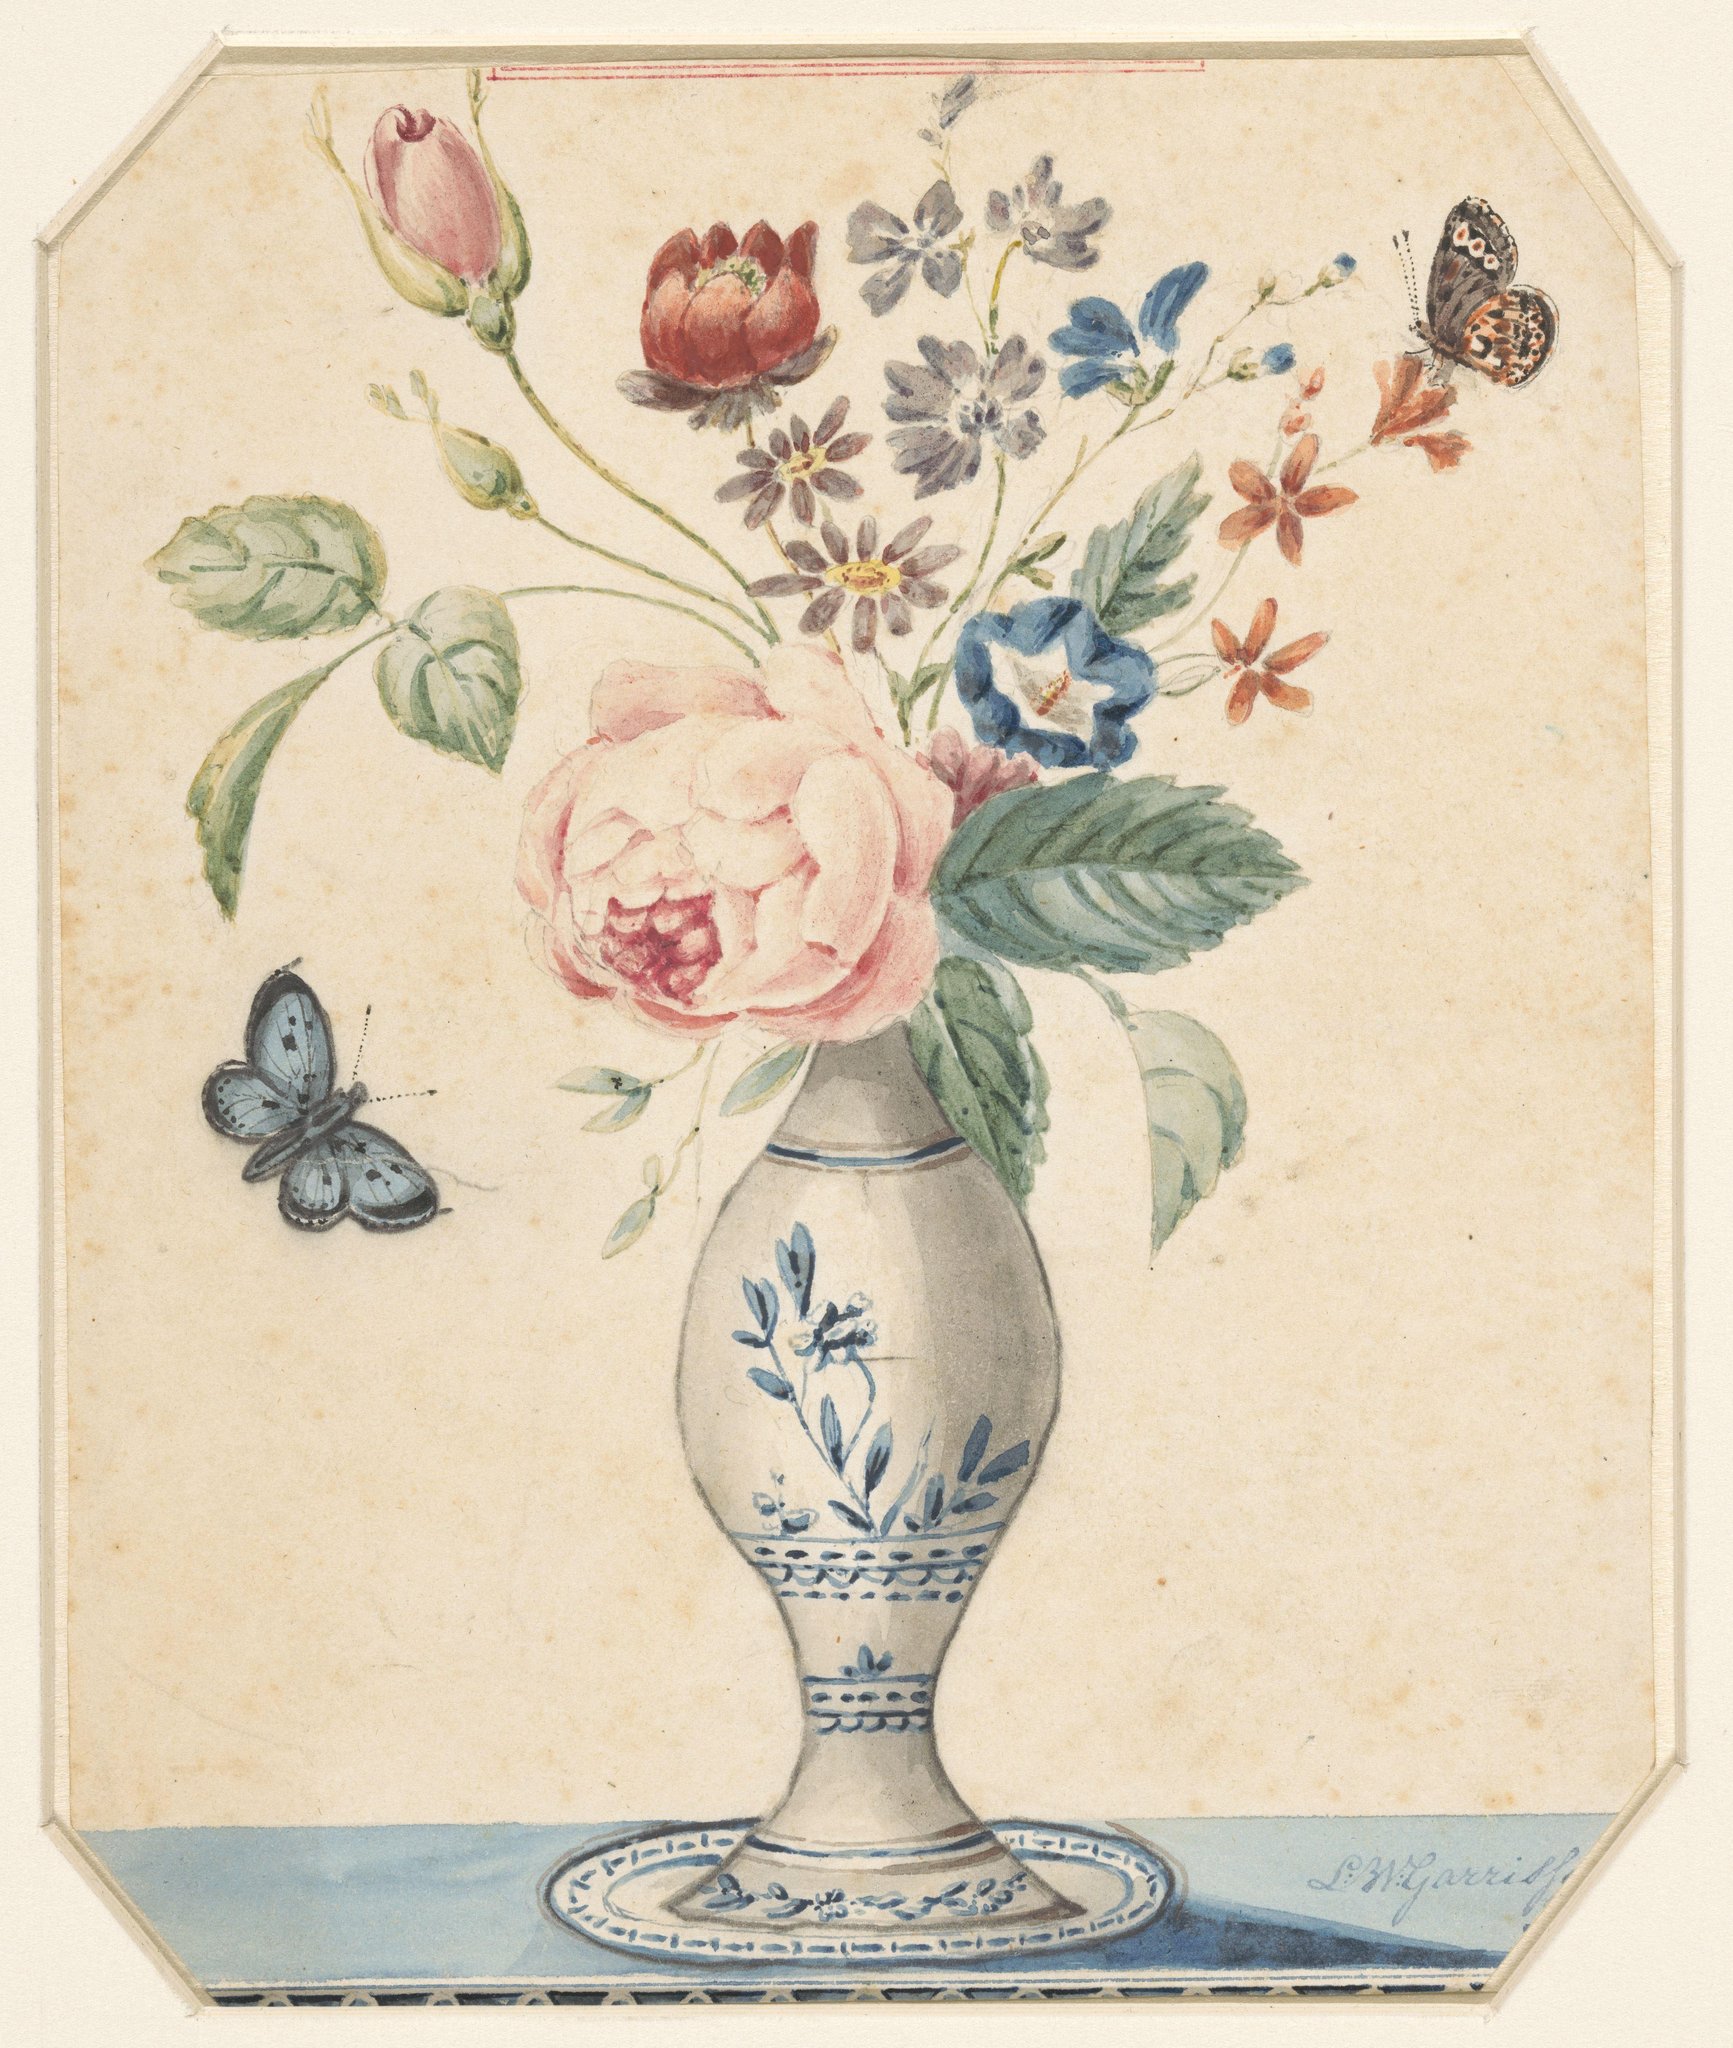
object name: drawing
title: Vaasje met bloemen en een blauwe vlinder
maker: l.w. garrison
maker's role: draughtsman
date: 1800-1900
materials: ink, paper, watercolor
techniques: brush, pen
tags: insects: butterfly, flowers in a vase